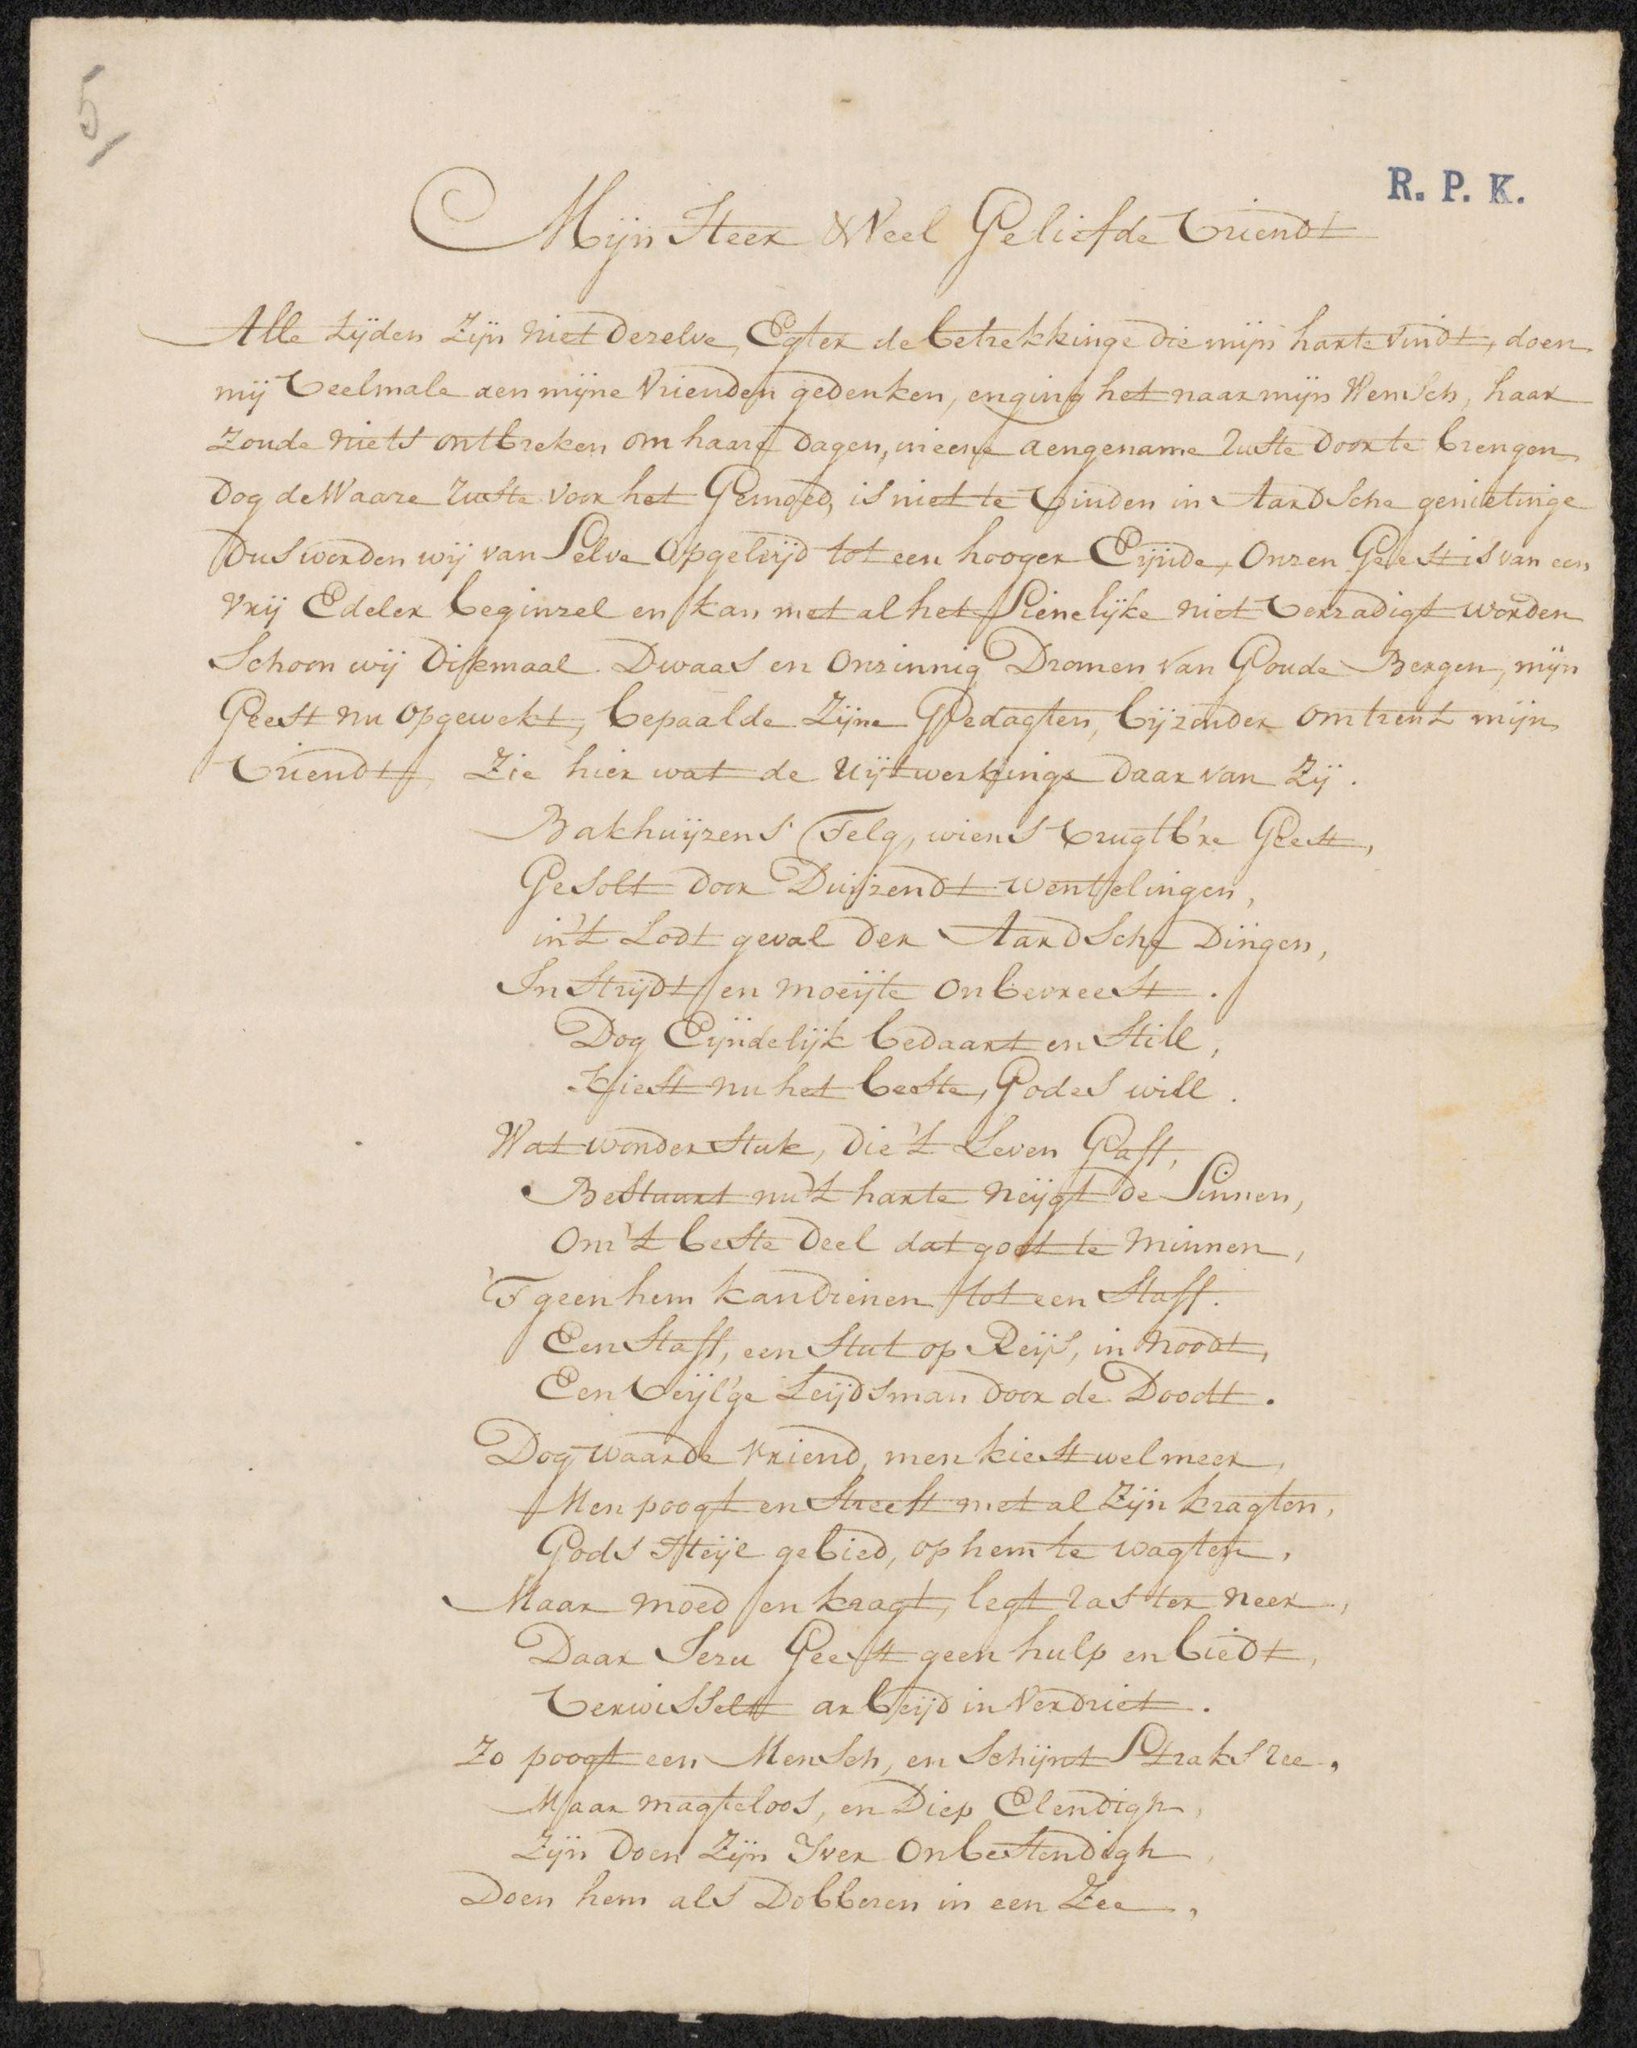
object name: letter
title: Brief aan Ludolf Backhuysen (II)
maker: frans de bergh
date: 1763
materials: ink, paper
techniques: pen, writing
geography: rotterdam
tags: rotterdam, christian religion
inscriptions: watermark, collector's mark: Lugt 2233